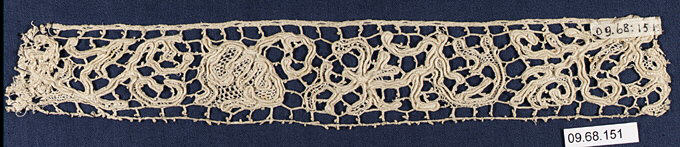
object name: fragment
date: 1601-1700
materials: linen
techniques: lace